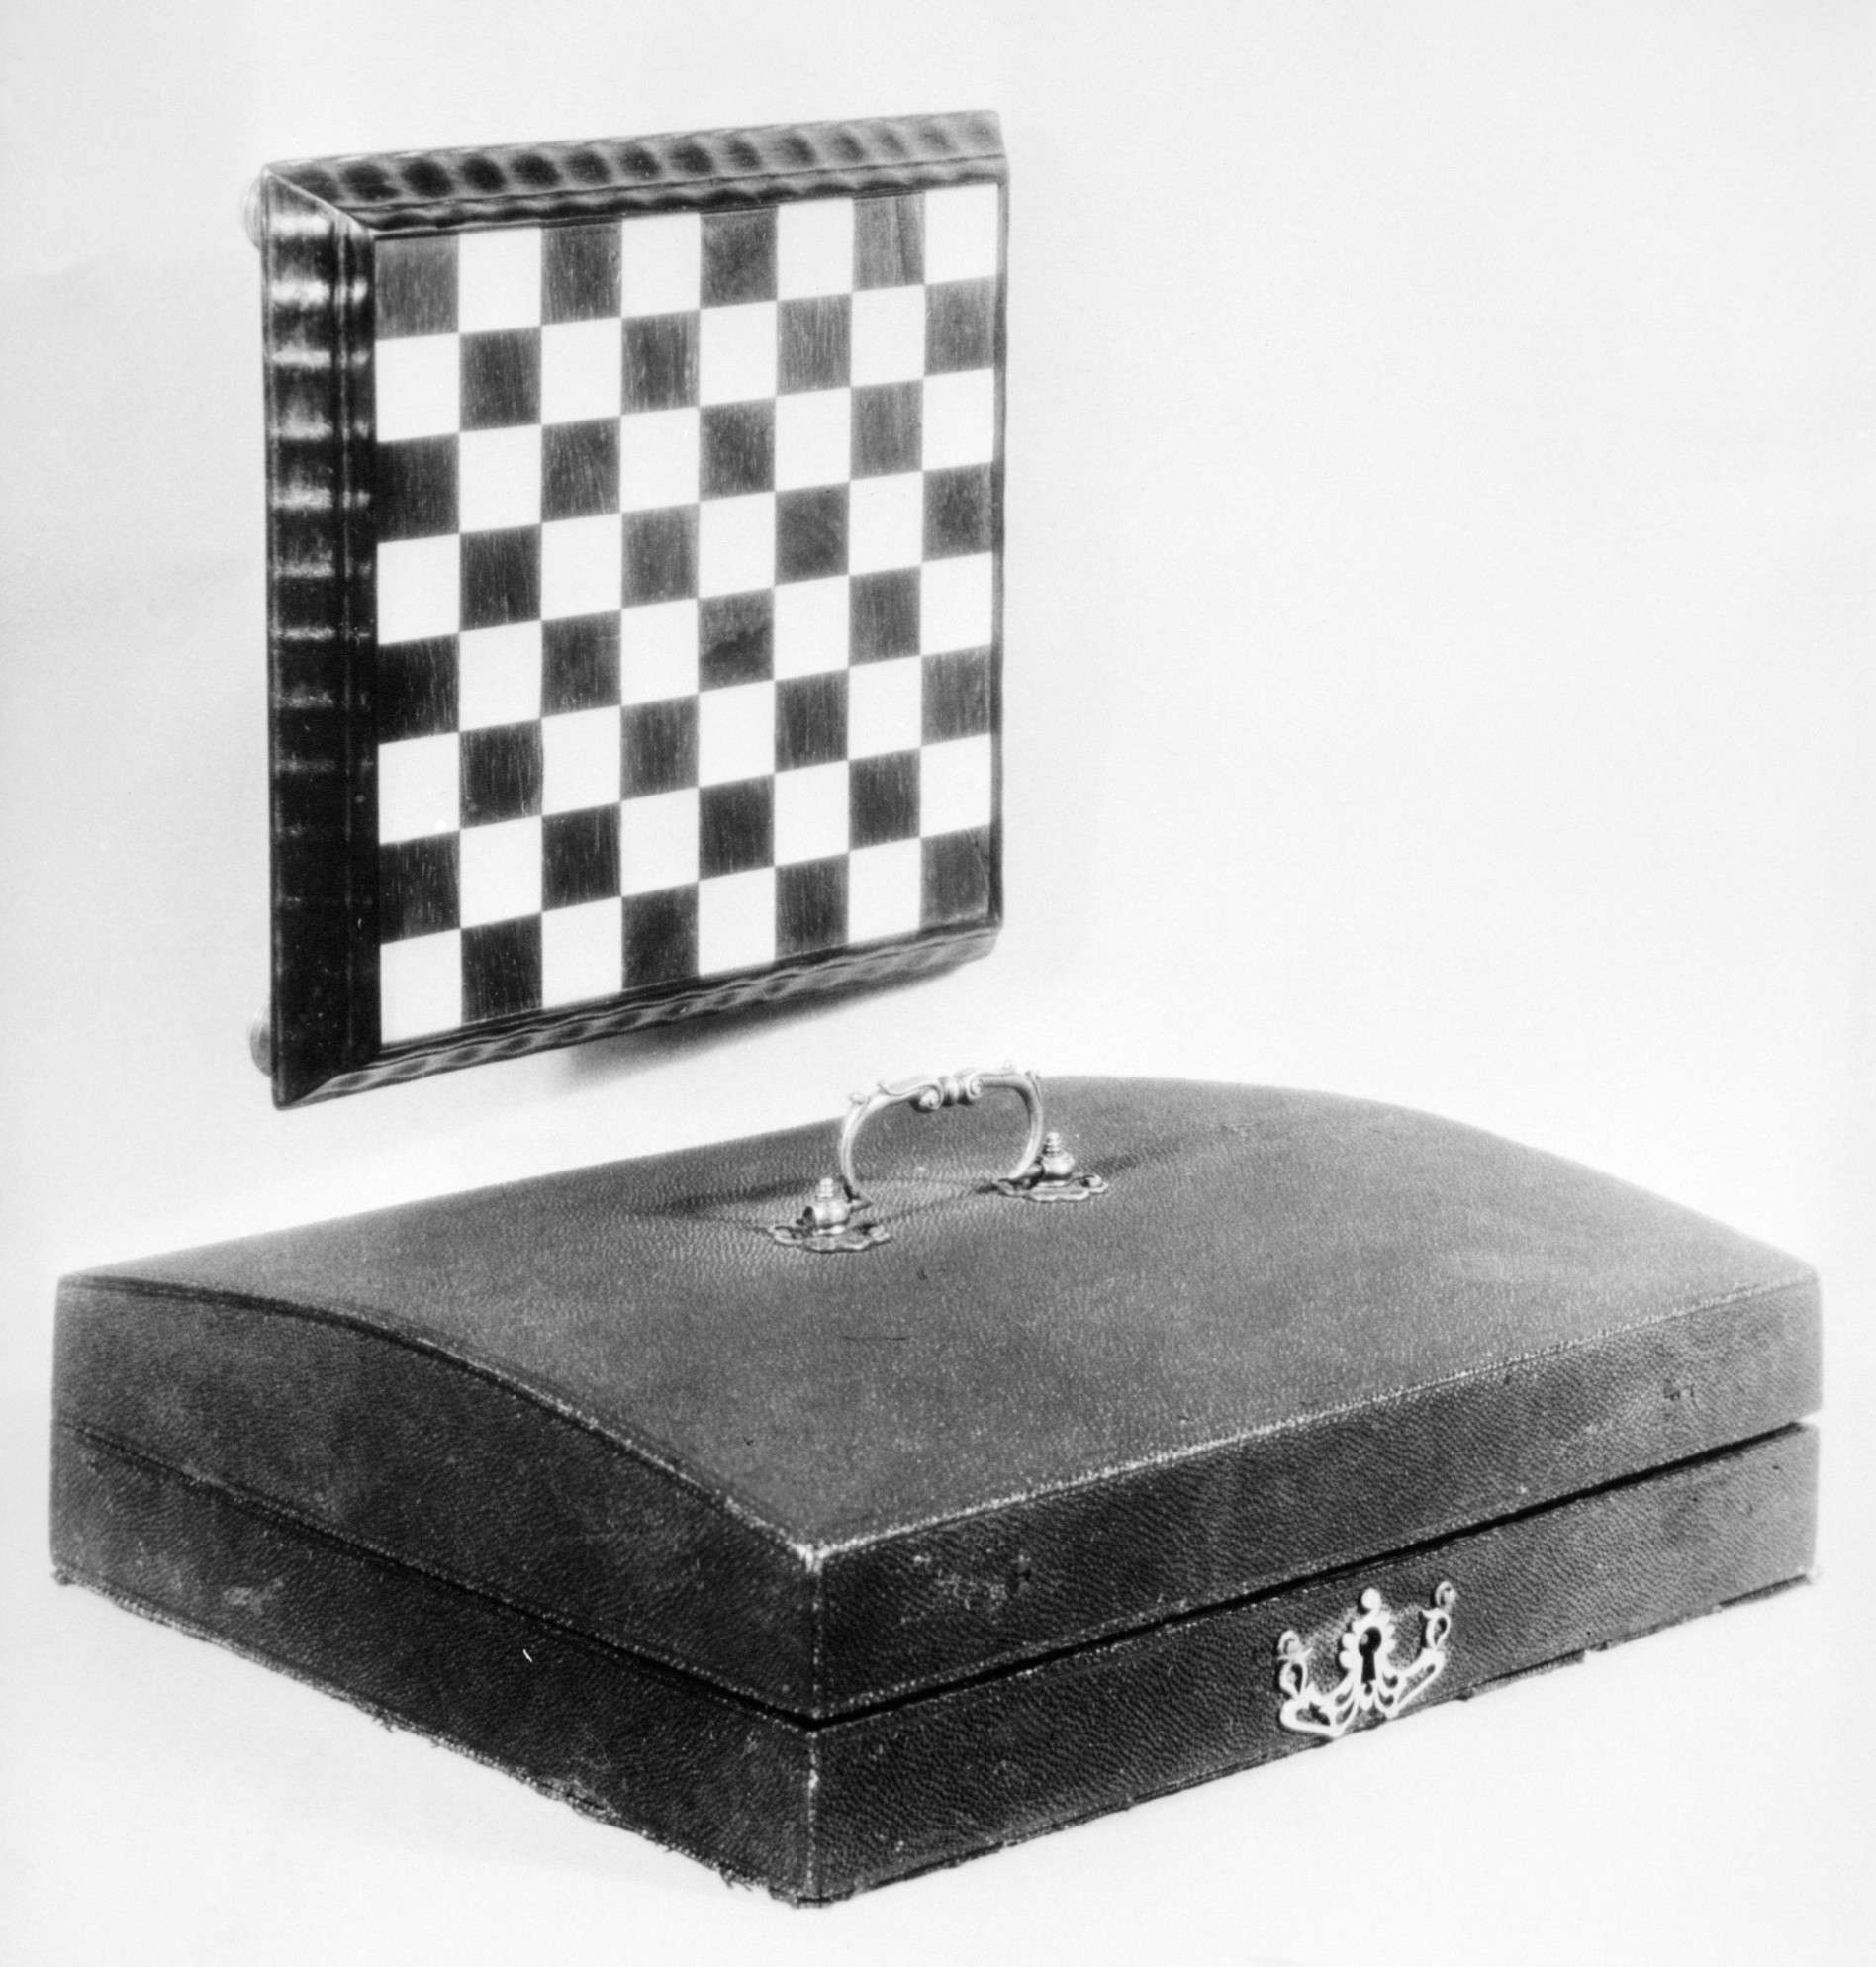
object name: chess set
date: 1801-1850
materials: gold, silver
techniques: filigree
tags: chess